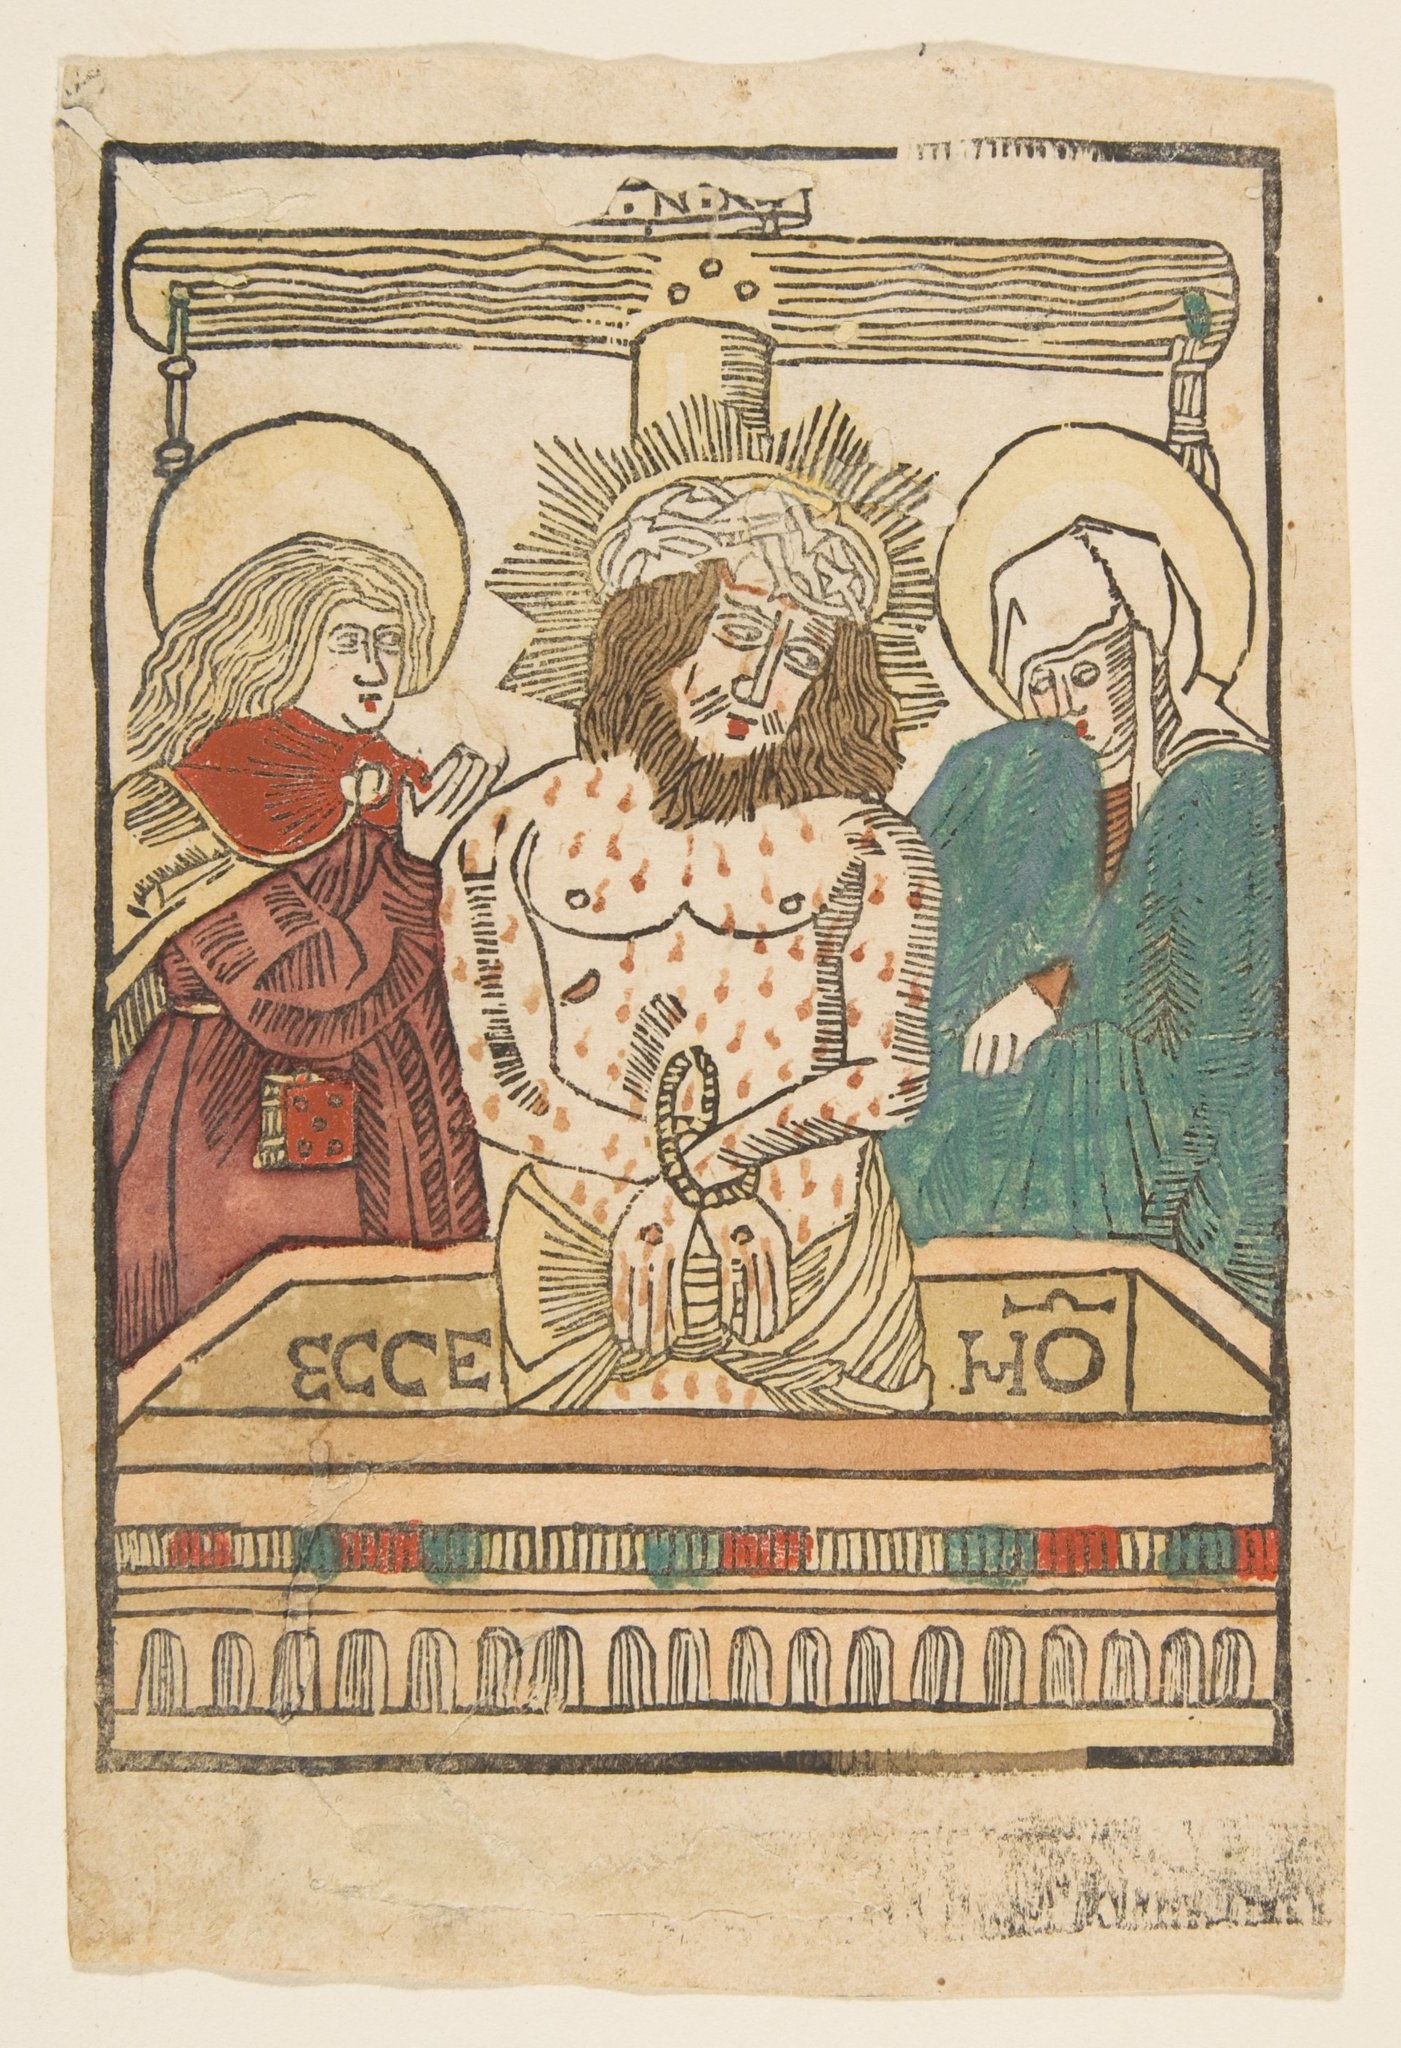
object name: print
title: The Man of Sorrows between the Virgin and Saint John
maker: anonymous, german, 15th century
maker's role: artist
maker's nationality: german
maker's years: 1400-1500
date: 1401-1500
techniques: hand coloring, woodcut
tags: christ,saint john the baptist,virgin mary